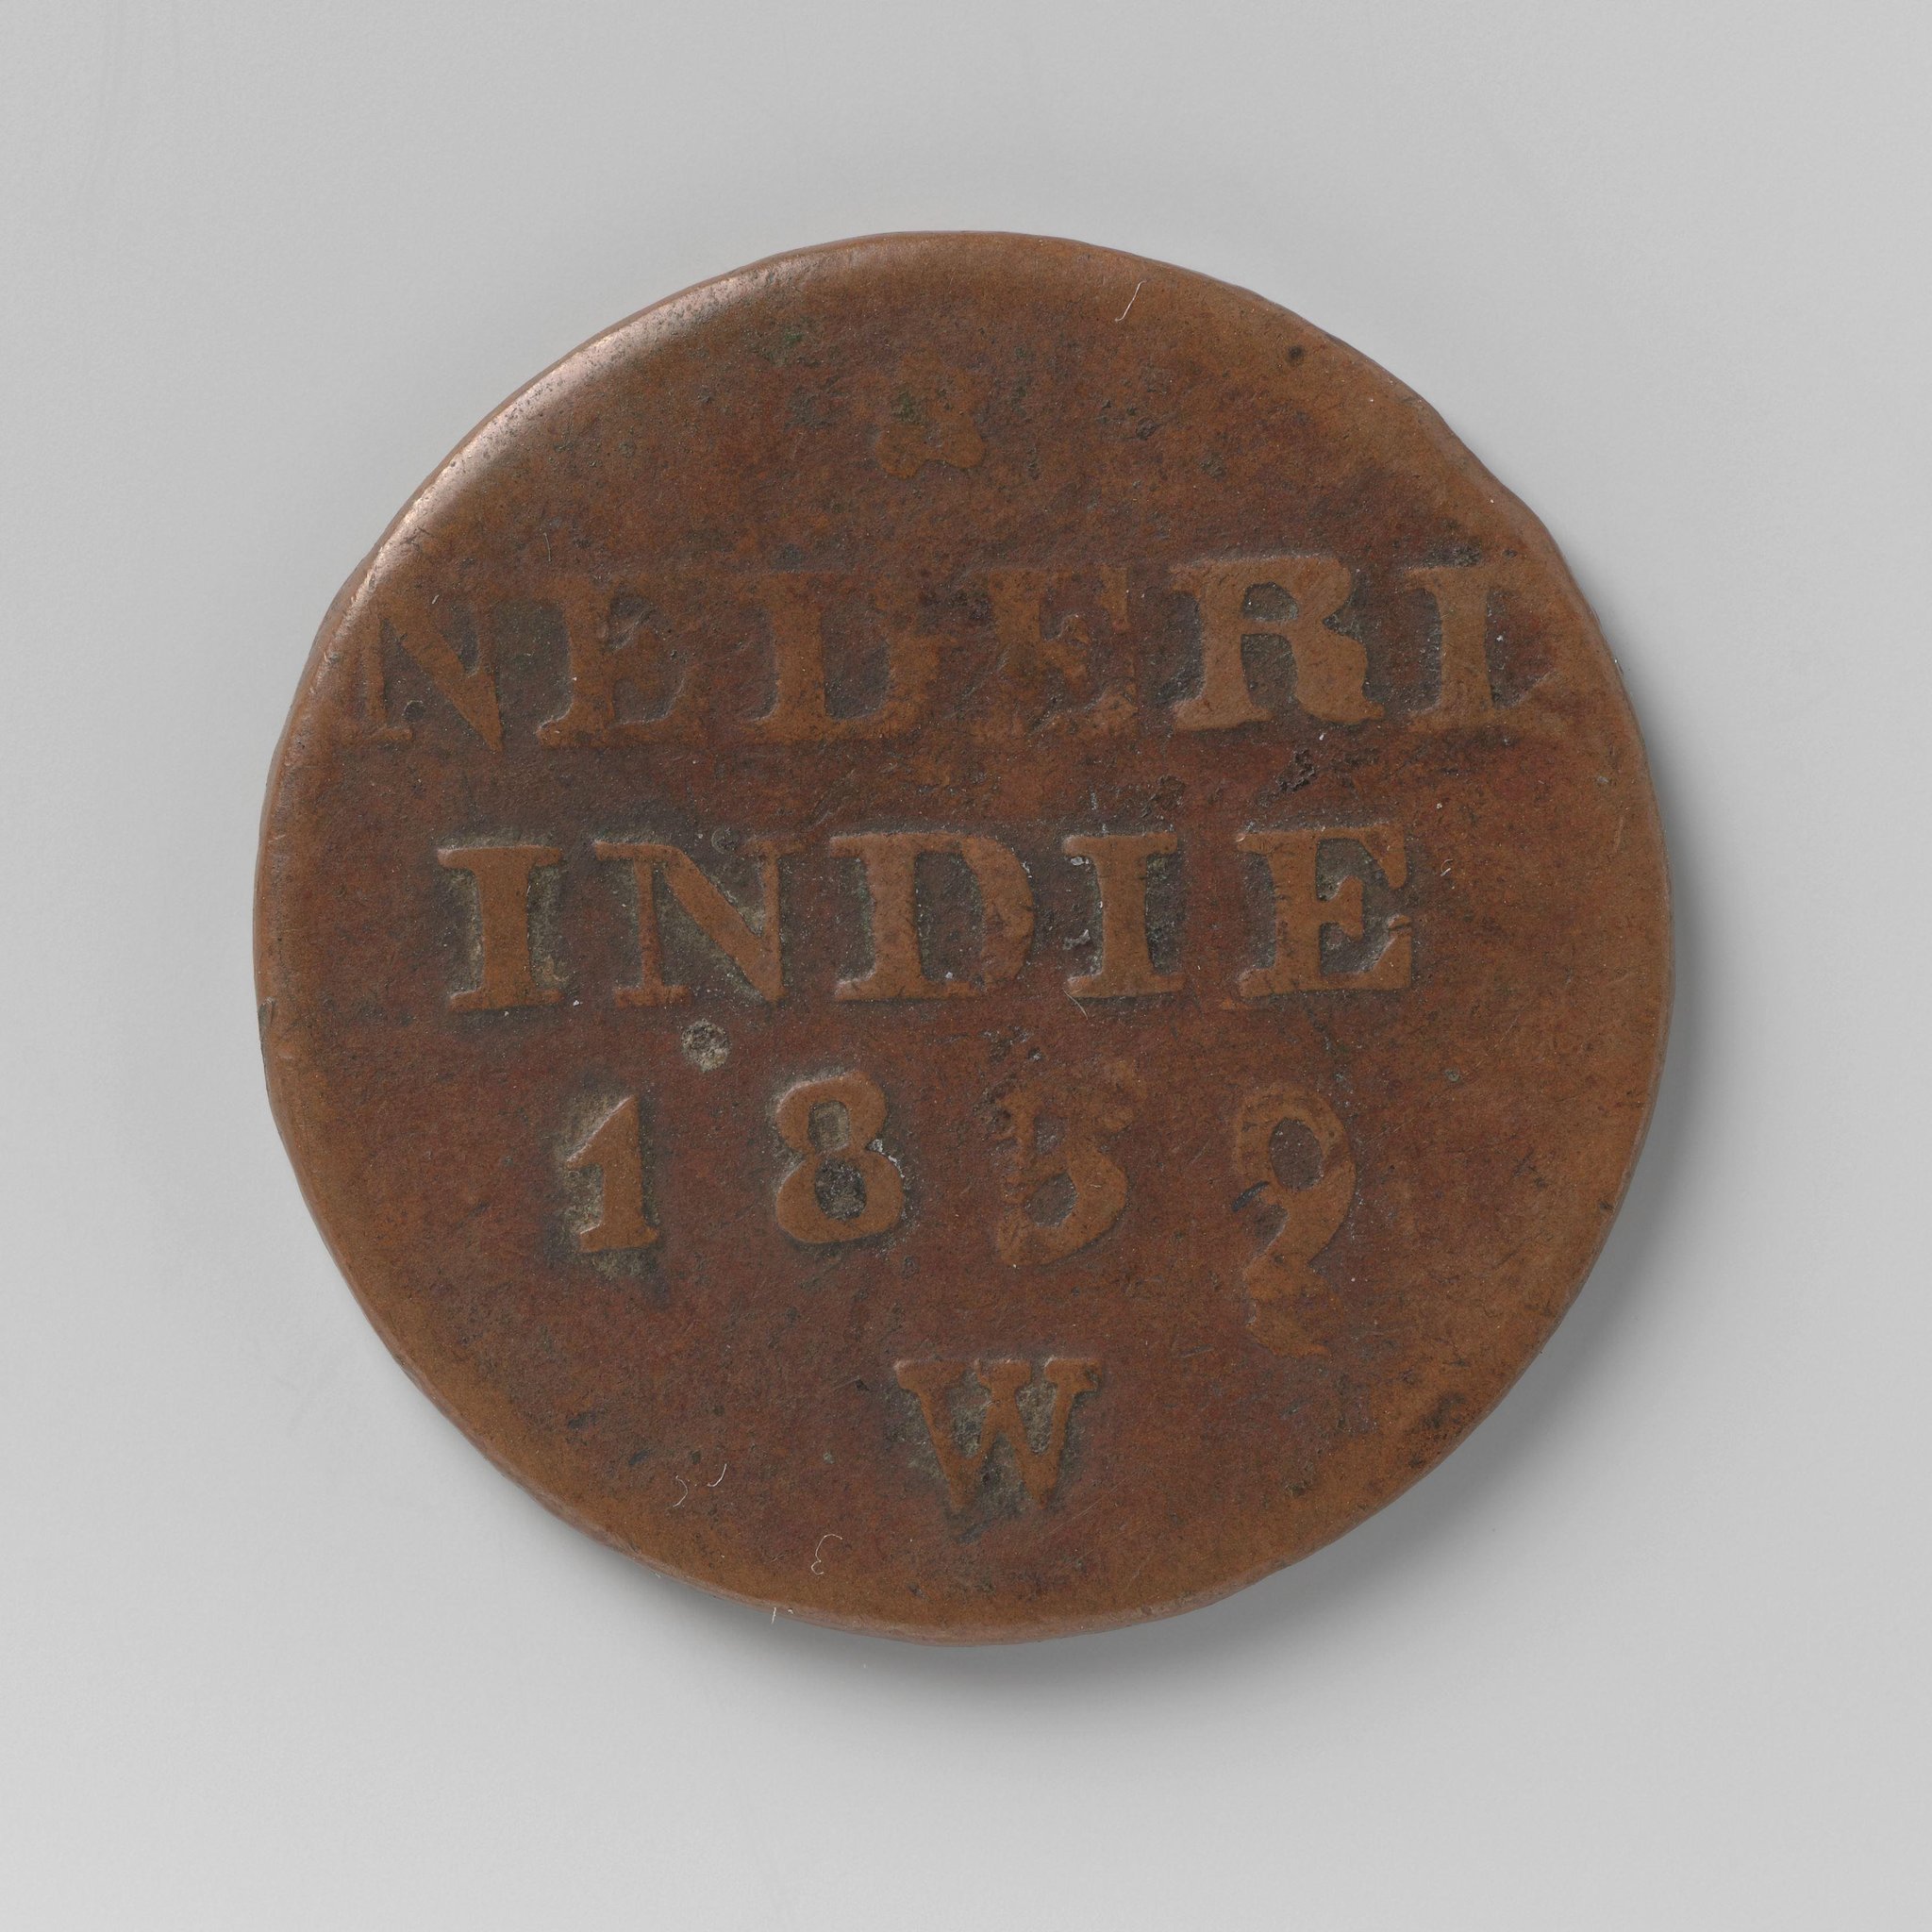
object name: coin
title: Nederlands Indië, 2 cent,1839 W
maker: william i of the netherlands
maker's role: koning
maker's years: 1772-1843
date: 1839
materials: copper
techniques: striking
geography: surabaya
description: Koperen munt. Voorzijde: tussen waarde-aanduiding 2 CT. gekroond rijkswapenschild. Keerzijde: tweeregelig opschrift, waarboven muntteken en waaronder jaartal. Daaronder letter W [=muntmeester Wilmans]. Gladde rand.